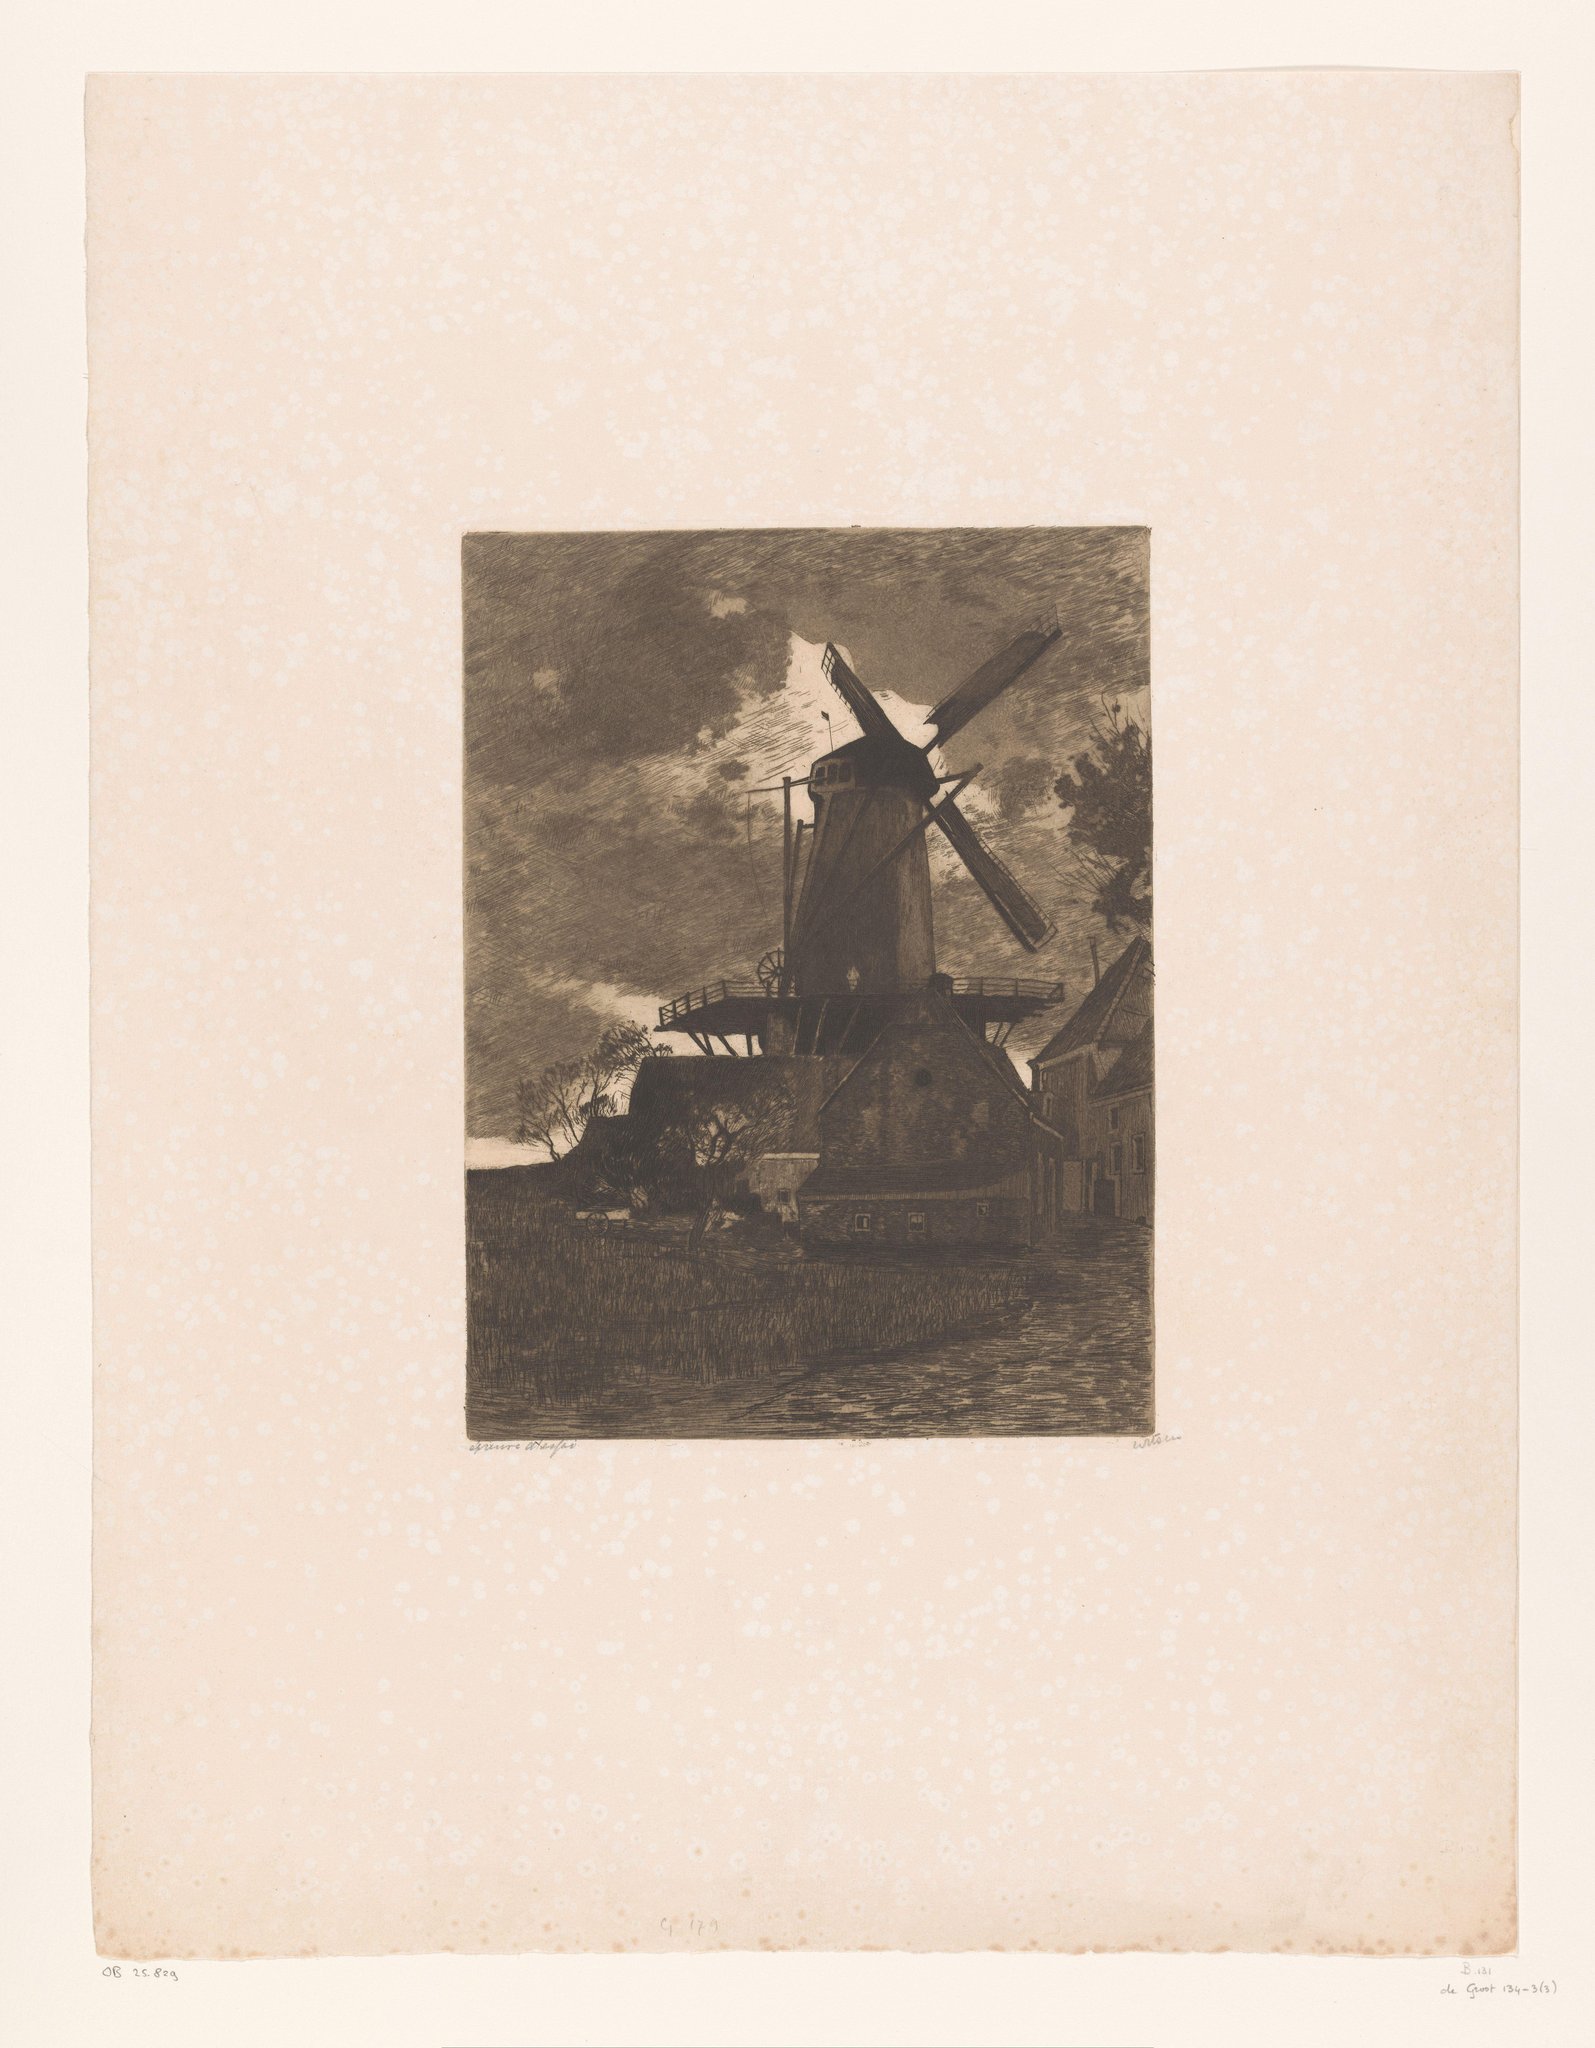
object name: print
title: Korenmolen, Wijk bij Duurstede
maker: willem witsen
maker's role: draughtsman, painter, print maker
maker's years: 1860-1923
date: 1908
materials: paper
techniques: aquatint, etching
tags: windmill in landscape, windmill, wijk bij duurstede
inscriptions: annotation: ‘épreuve d'essai’